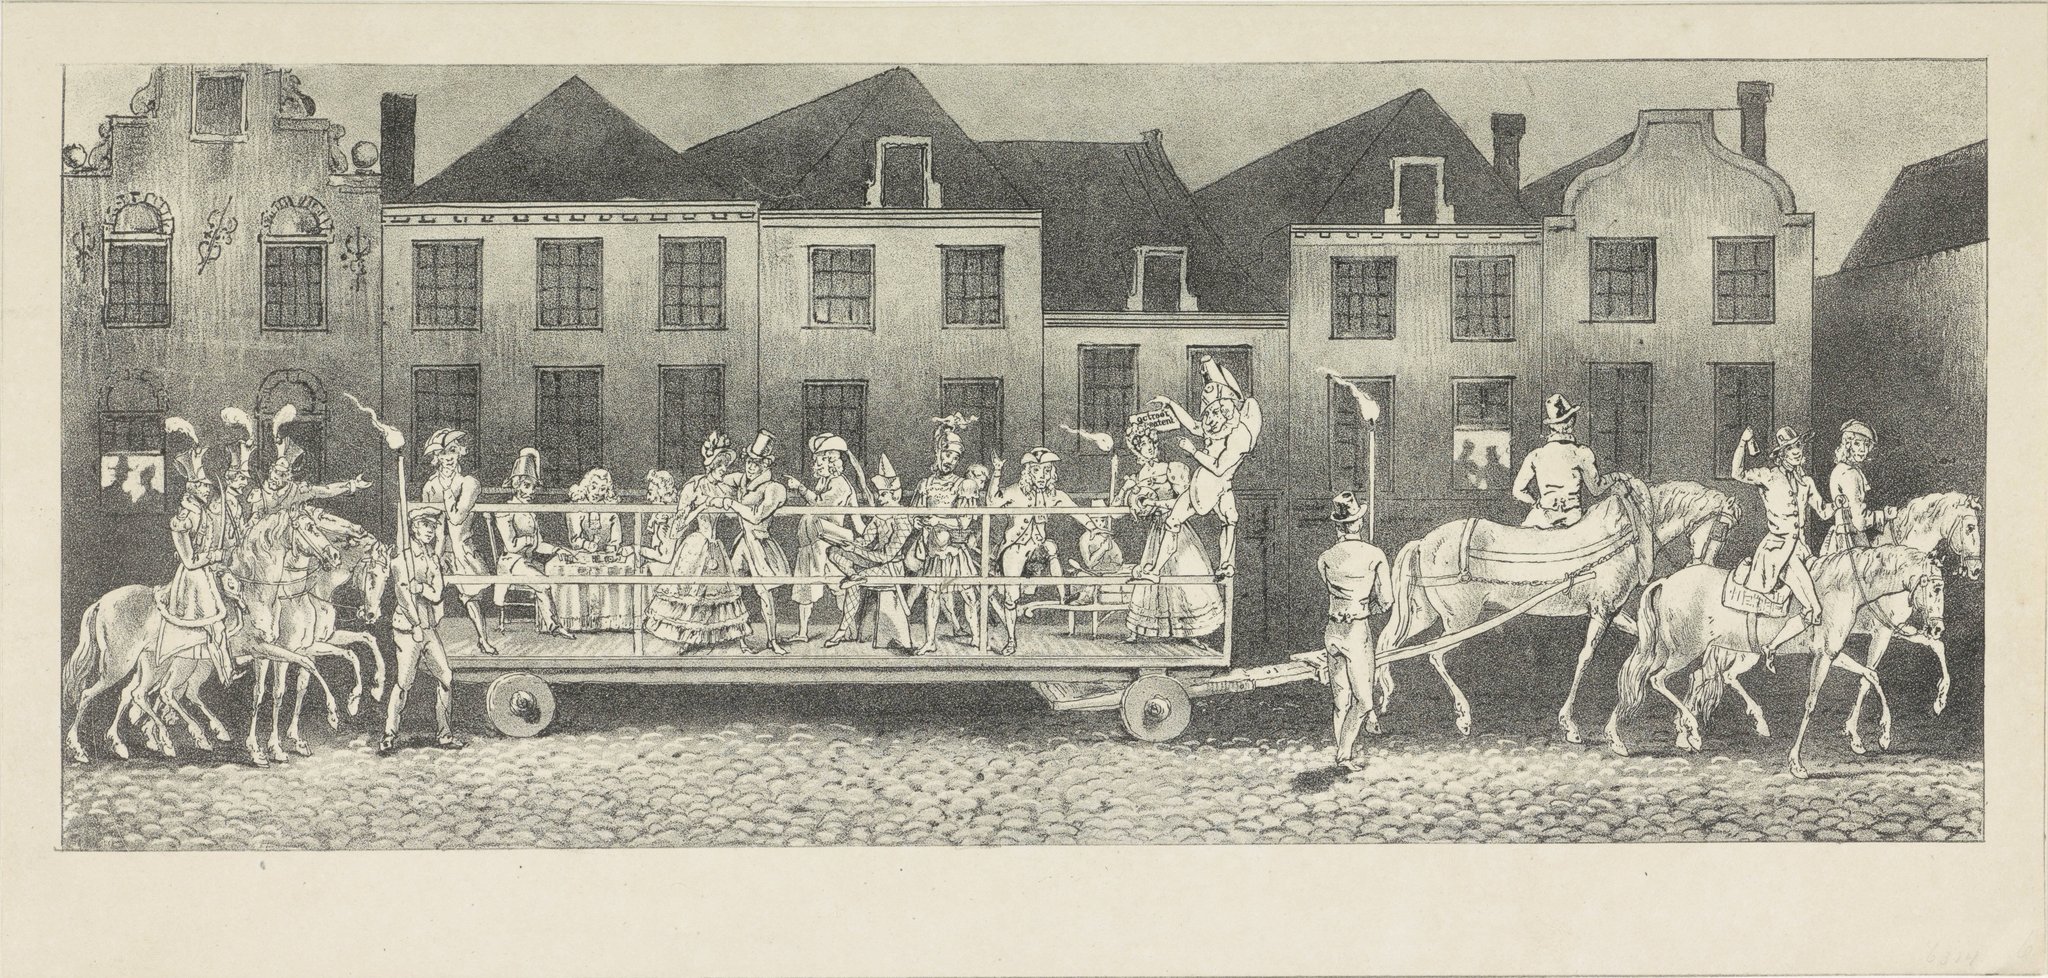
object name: print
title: Optocht in maskerade (plaat 6), 1829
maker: johannes paulus houtman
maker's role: bookseller, print maker, printer, publisher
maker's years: 1803-1845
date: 1829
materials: paper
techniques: lithograph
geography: netherlands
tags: students' pageant, masquerade, masked ball, utrecht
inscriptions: collector's mark: Lugt 2228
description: Optocht in maskerade van Utrechtse studenten ter viering van de Dies Natalis van de universiteit van Utrecht op 26 maart 1829. Plaat 6: Stoet met ruiters en een praalwagen waarop een toneelstukje 'octrooi patent' wordt opgevoerd. Onderdeel van een groep van zeven platen die samen een lange fries vormen.